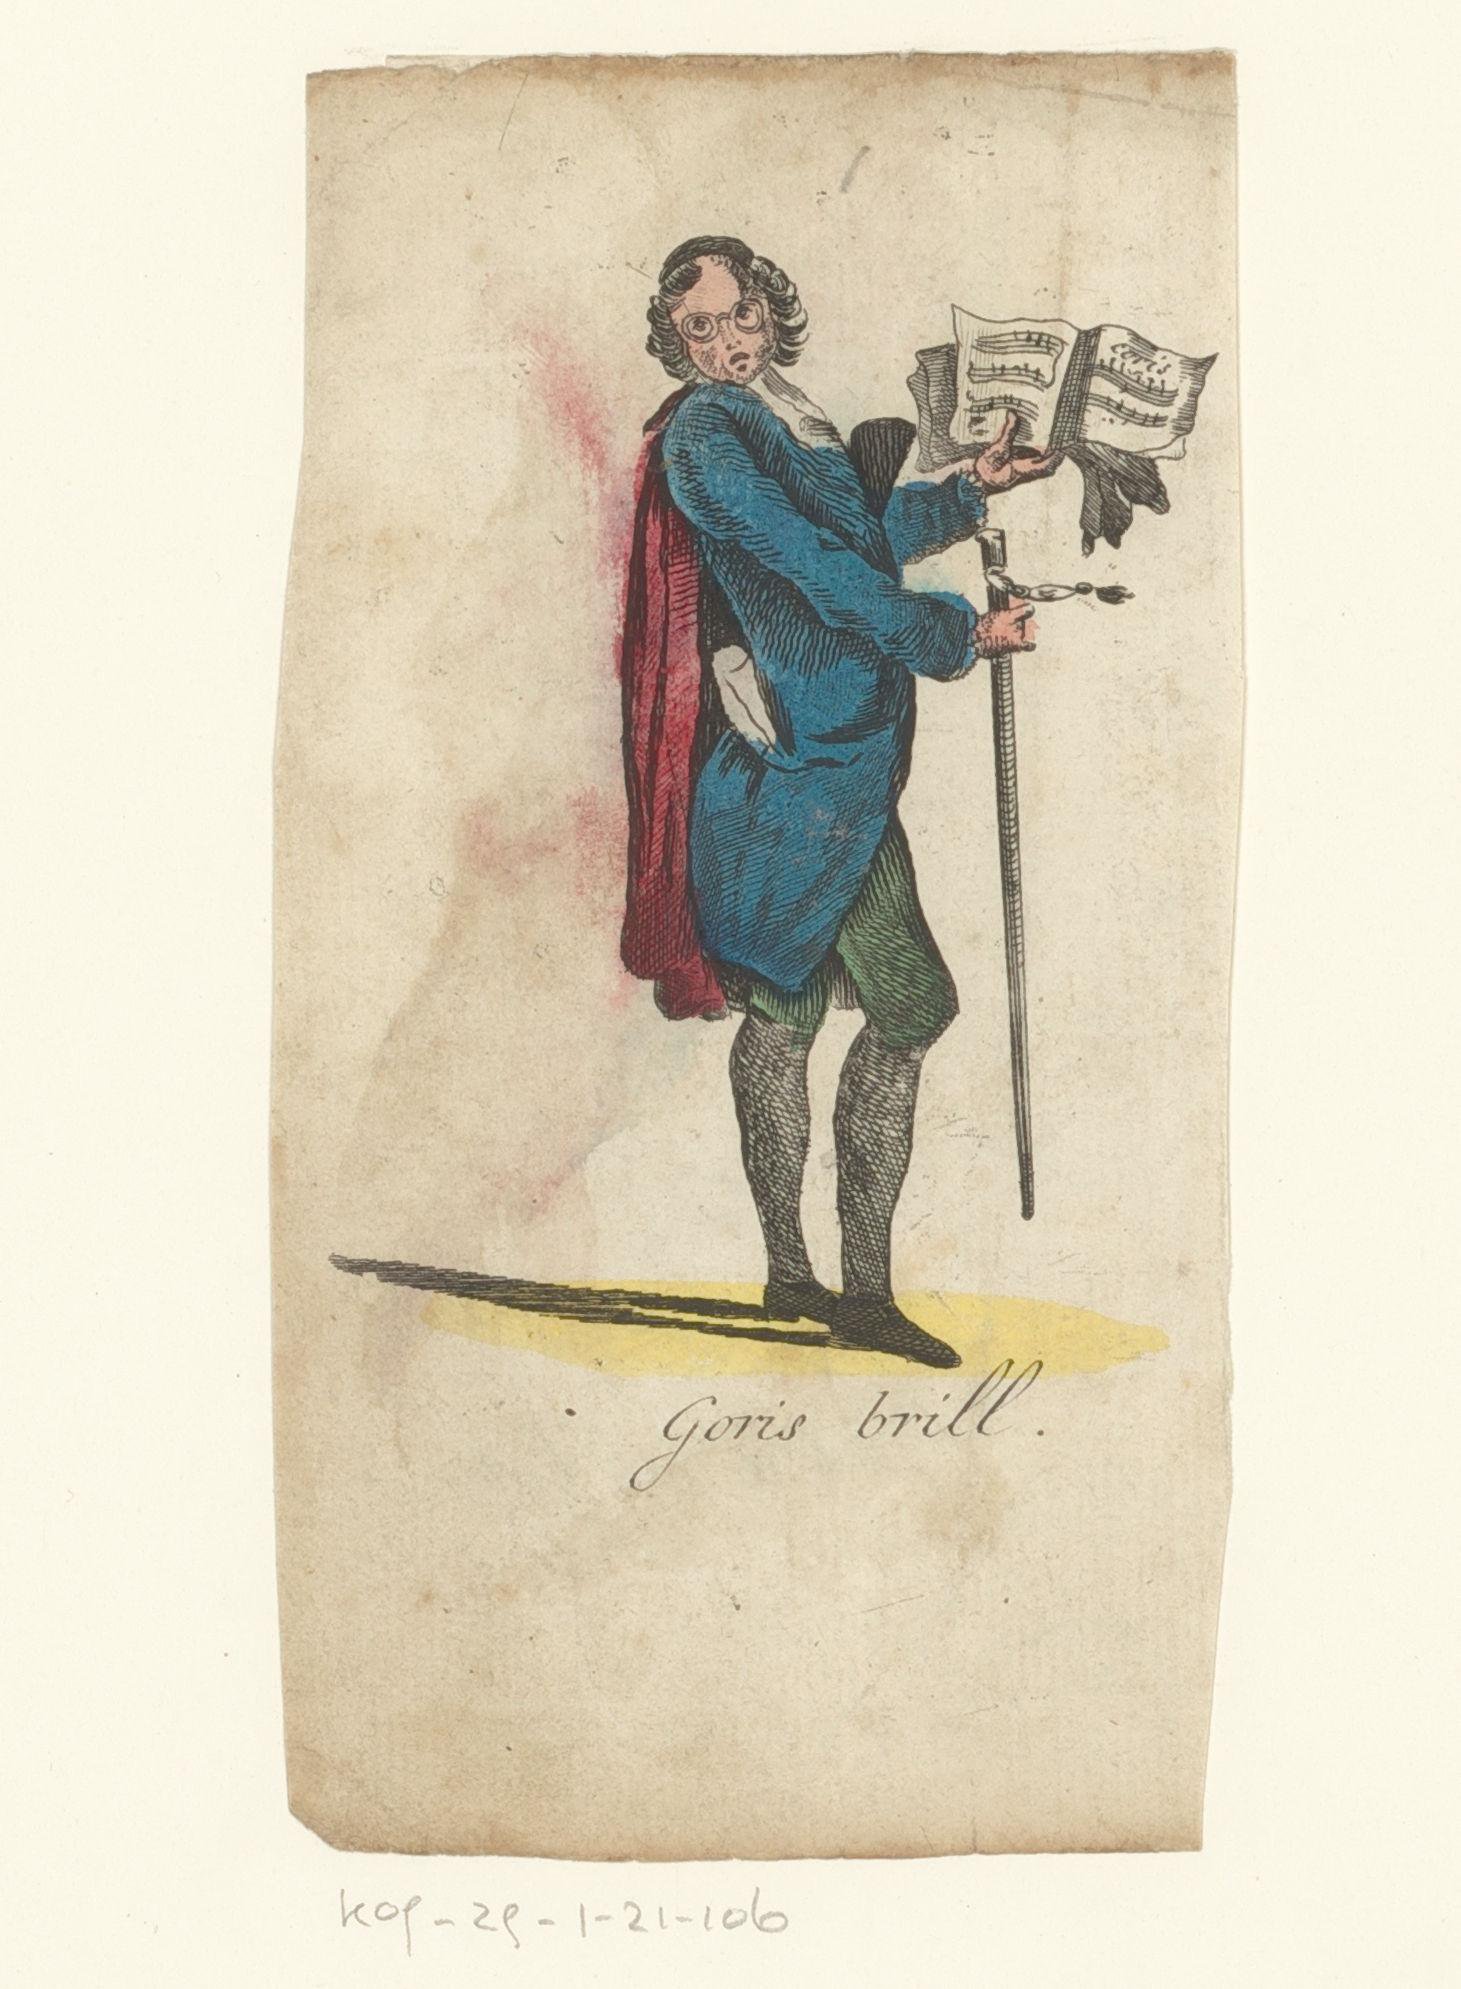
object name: print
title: Goris Brill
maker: Anonymous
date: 1793-1800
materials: paper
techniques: engraving, etching, hand coloring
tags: musician at work, male singer - cc - out of doors, teacher and pupil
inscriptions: collector's mark: Lugt 1641a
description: Italiaanse zangleraar, genaamd Goril Brill met bladmuziek in zijn hand. Onderwerpsrubrieken binnen de Atlas Zeden en Gewoonten: Zeden en Gewoonten in Engeren Zin, De Kleeding, Kleederdrachten (tijdvakken), De 18de eeuw (de revolutietijd). Mannen en vrouwen.